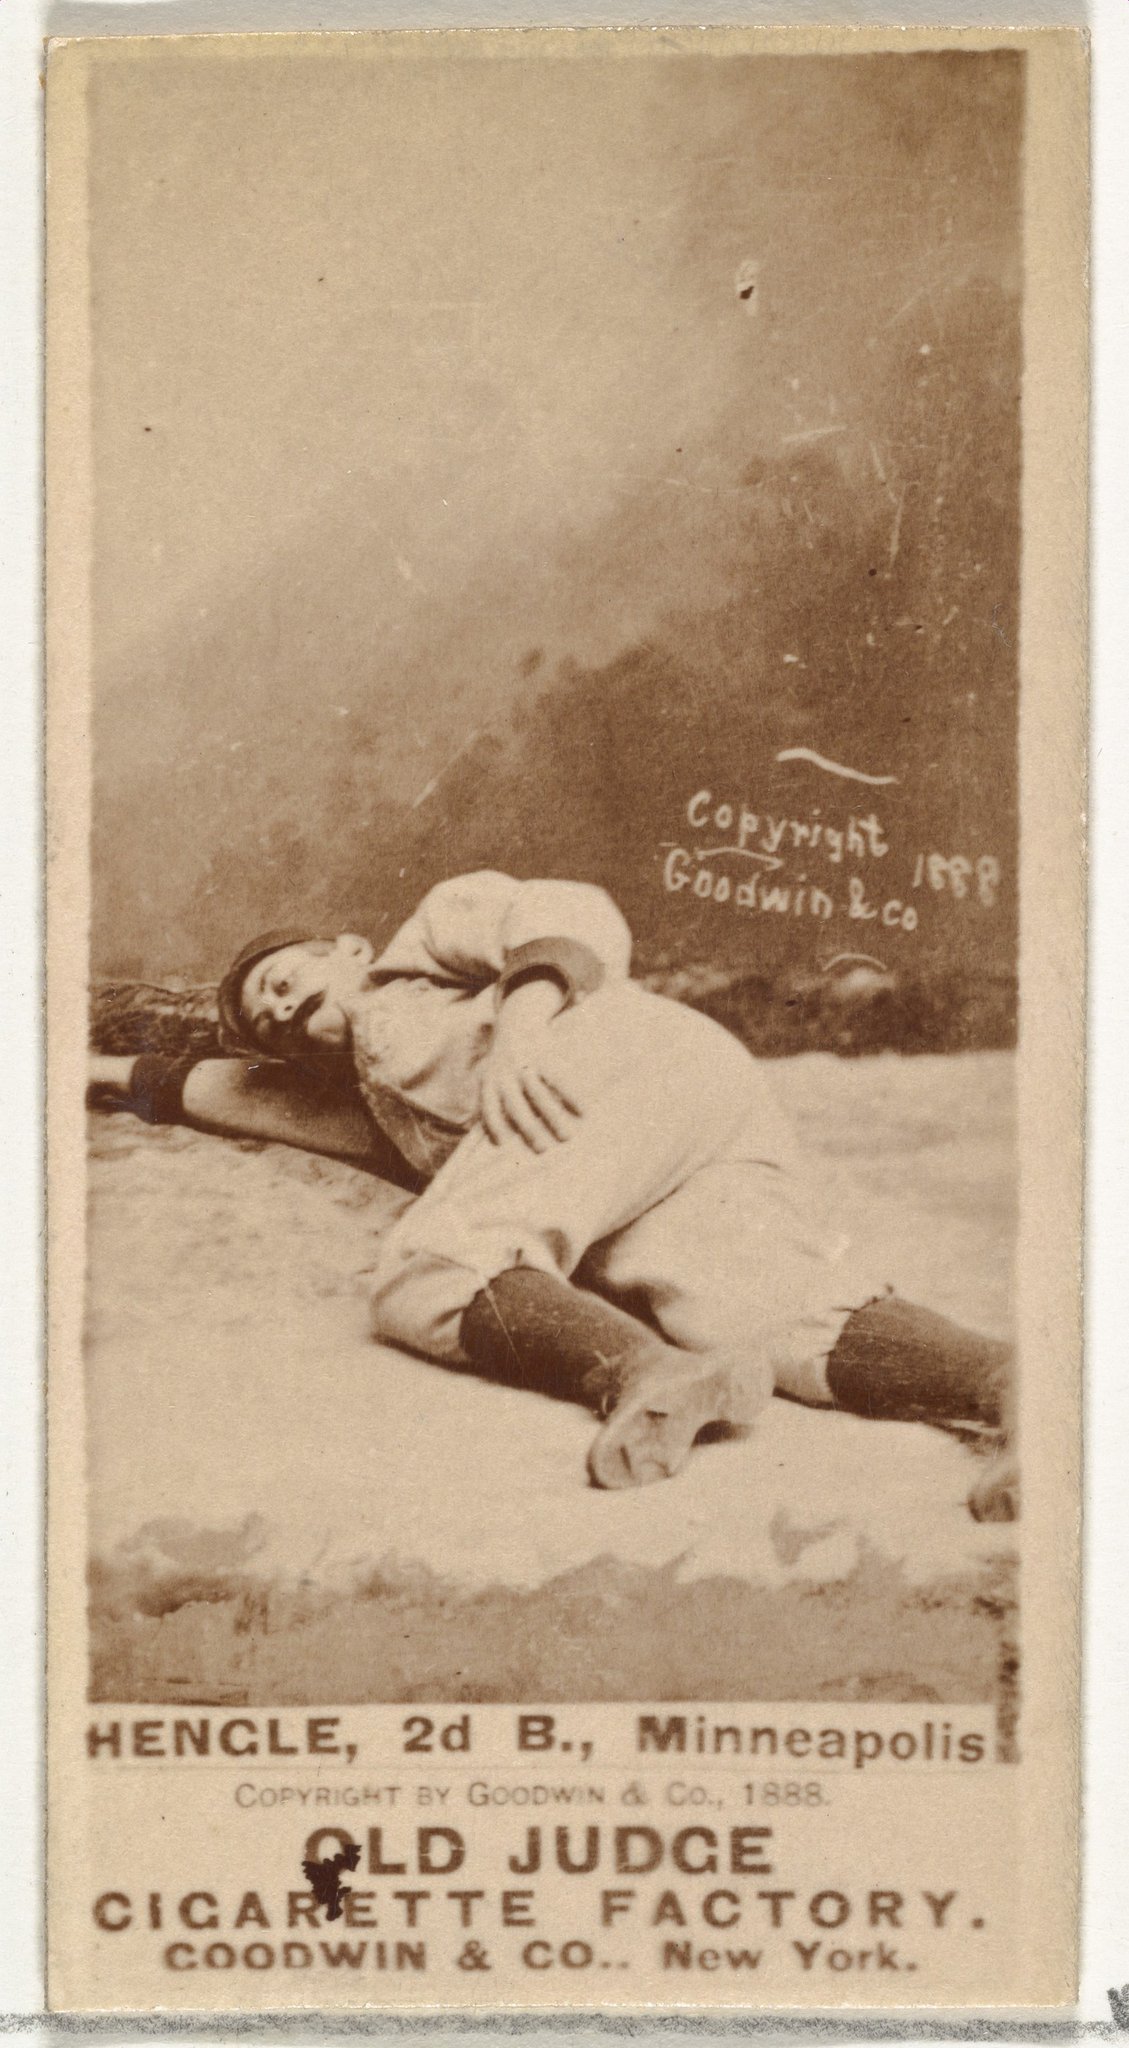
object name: baseball card, photograph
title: Emery J. "Moxie" Hengel, 2nd Base, Minneapolis, from the Old Judge series (N172) for Old Judge Cigarettes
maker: goodwin & company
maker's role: publisher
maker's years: 1850-1950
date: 1888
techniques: albumen silver print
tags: men,portraits,baseball,athletes